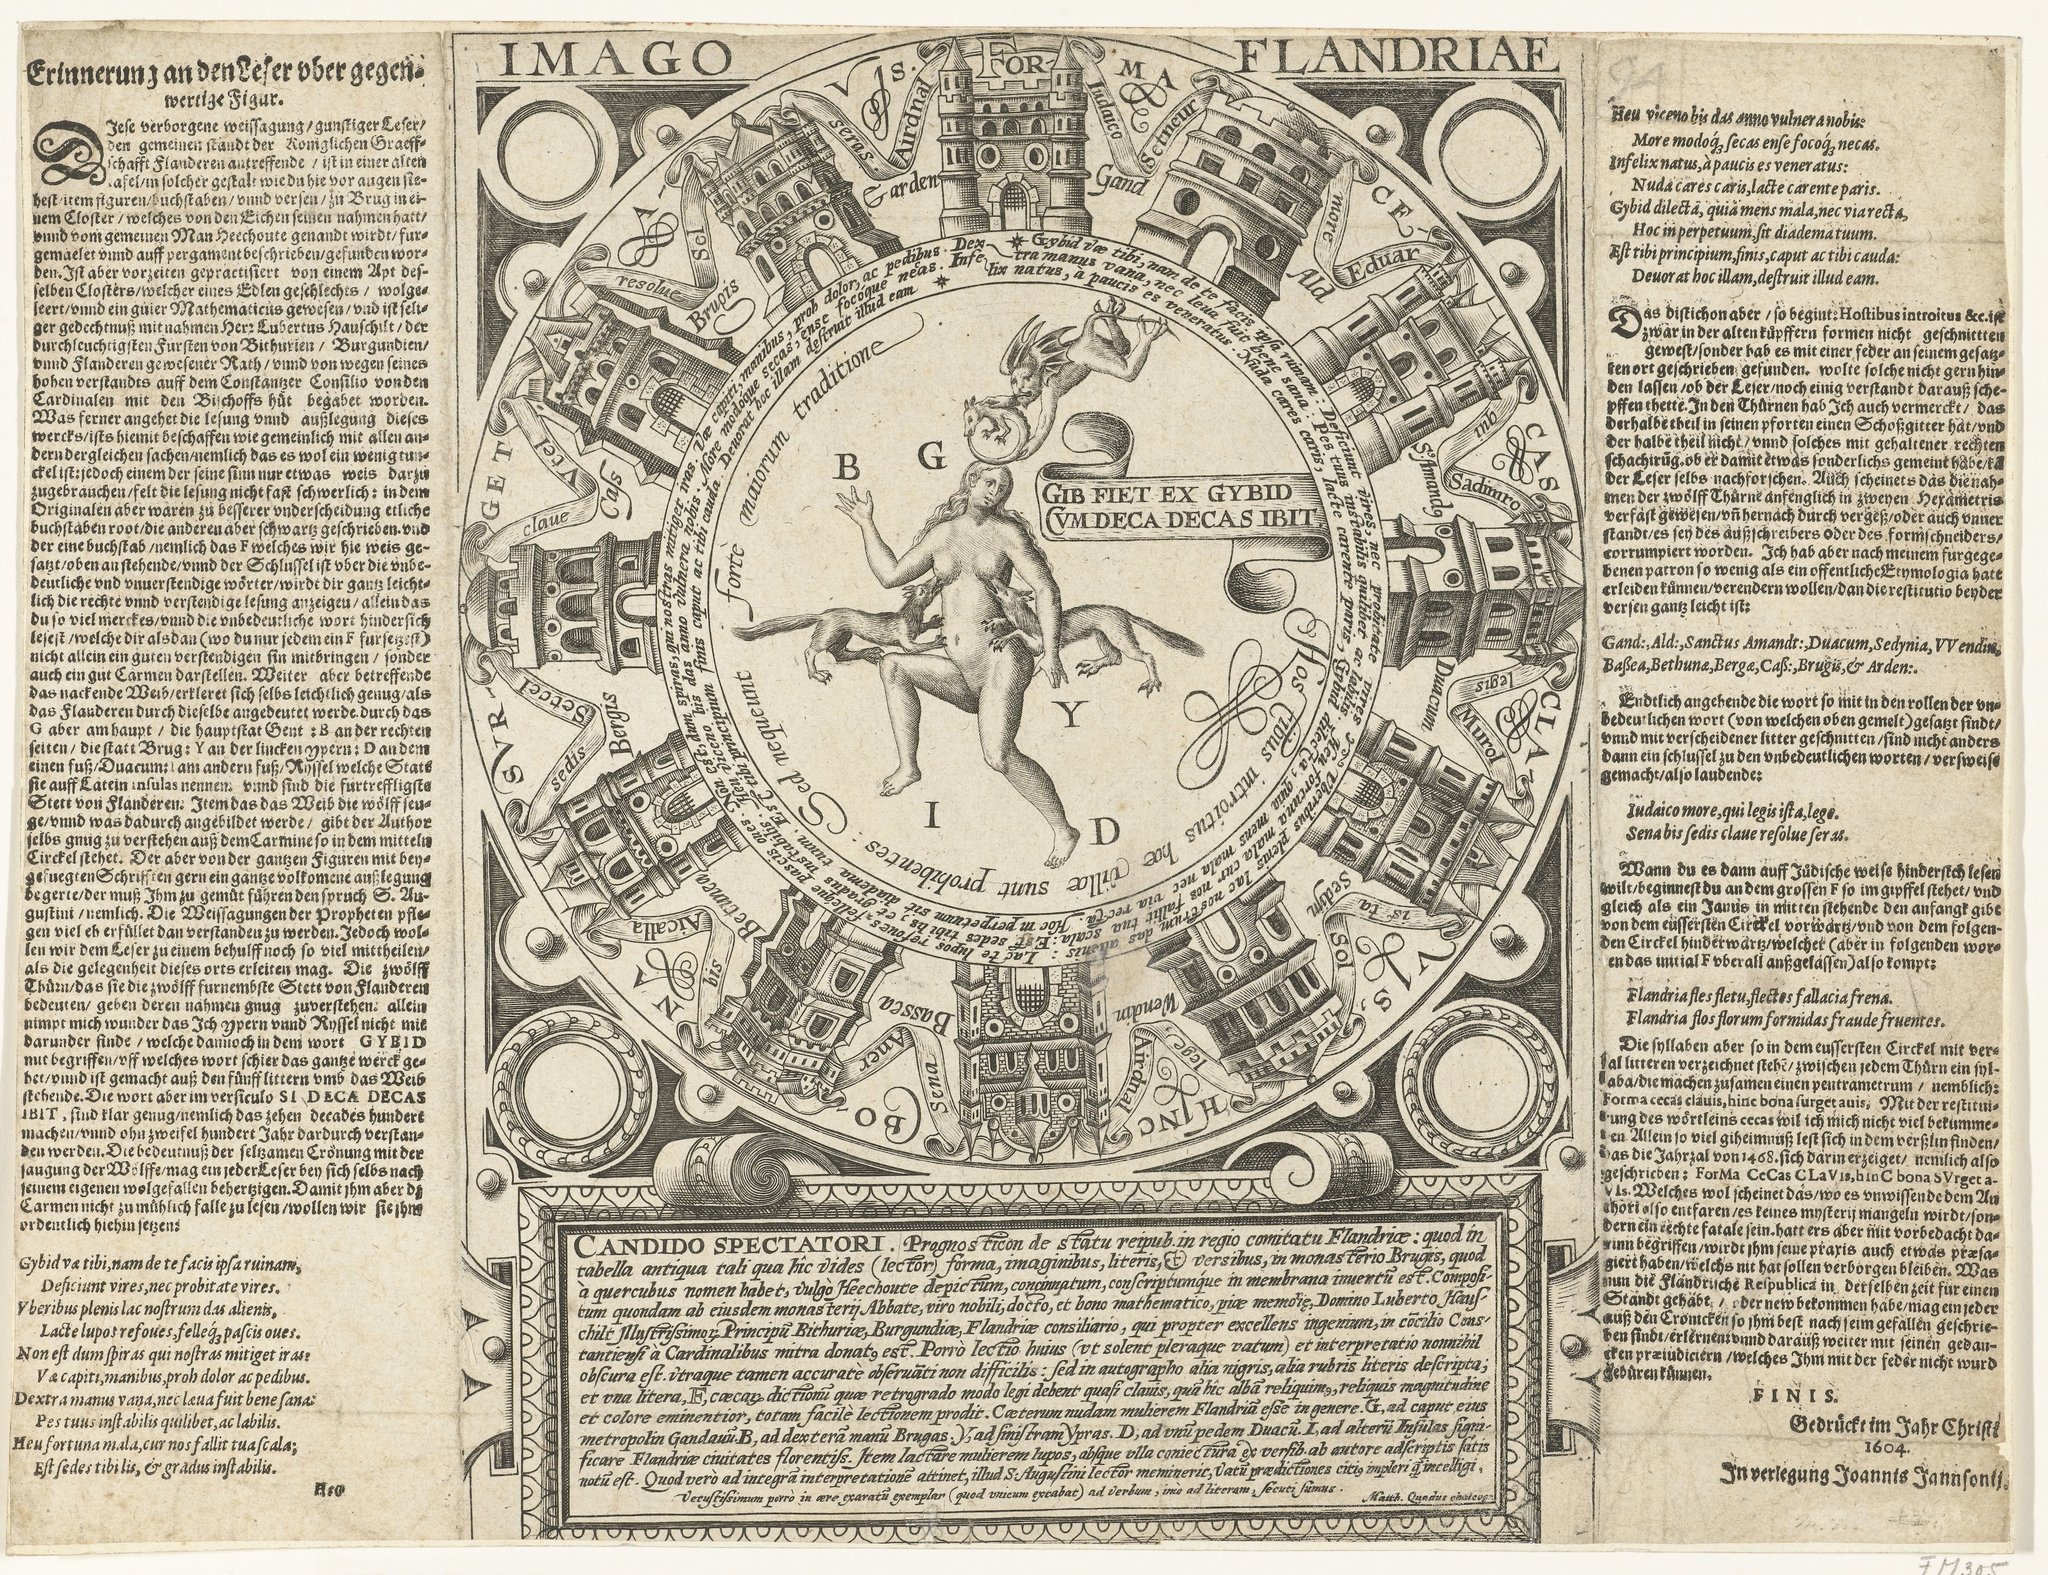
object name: print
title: Allegorie op de staat van Vlaanderen, 1604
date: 1604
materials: paper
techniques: engraving, letterpress printing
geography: northern netherlands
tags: earl, charles the bold (duke of burgundy), personifications of countries, nations, states, districts, etc., beasts of prey, predatory animals: wolf, ghent, lille, bruges, burgundian netherlands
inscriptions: date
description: Allegorie op de staat van Vlaanderen, 1604. Centraal een naakte vrouw die twee wolven aan haar borsten zoogt en gekroond wordt door een duivel. Profetie waarin een vergelijking wordt getrokken tussen de gebeurtenissen in Vlaanderen in het jaar 1468: de veldtochten van Karel de Stoute, het jaar 1568: aanvang van de Nederlandse Opstand en de Spaanse dreiging in het jaar 1604. Met onderschrift in het Latijn in cartouche en verklaring in het Duits in twee kolommen aan weerszijden van de voorstelling.